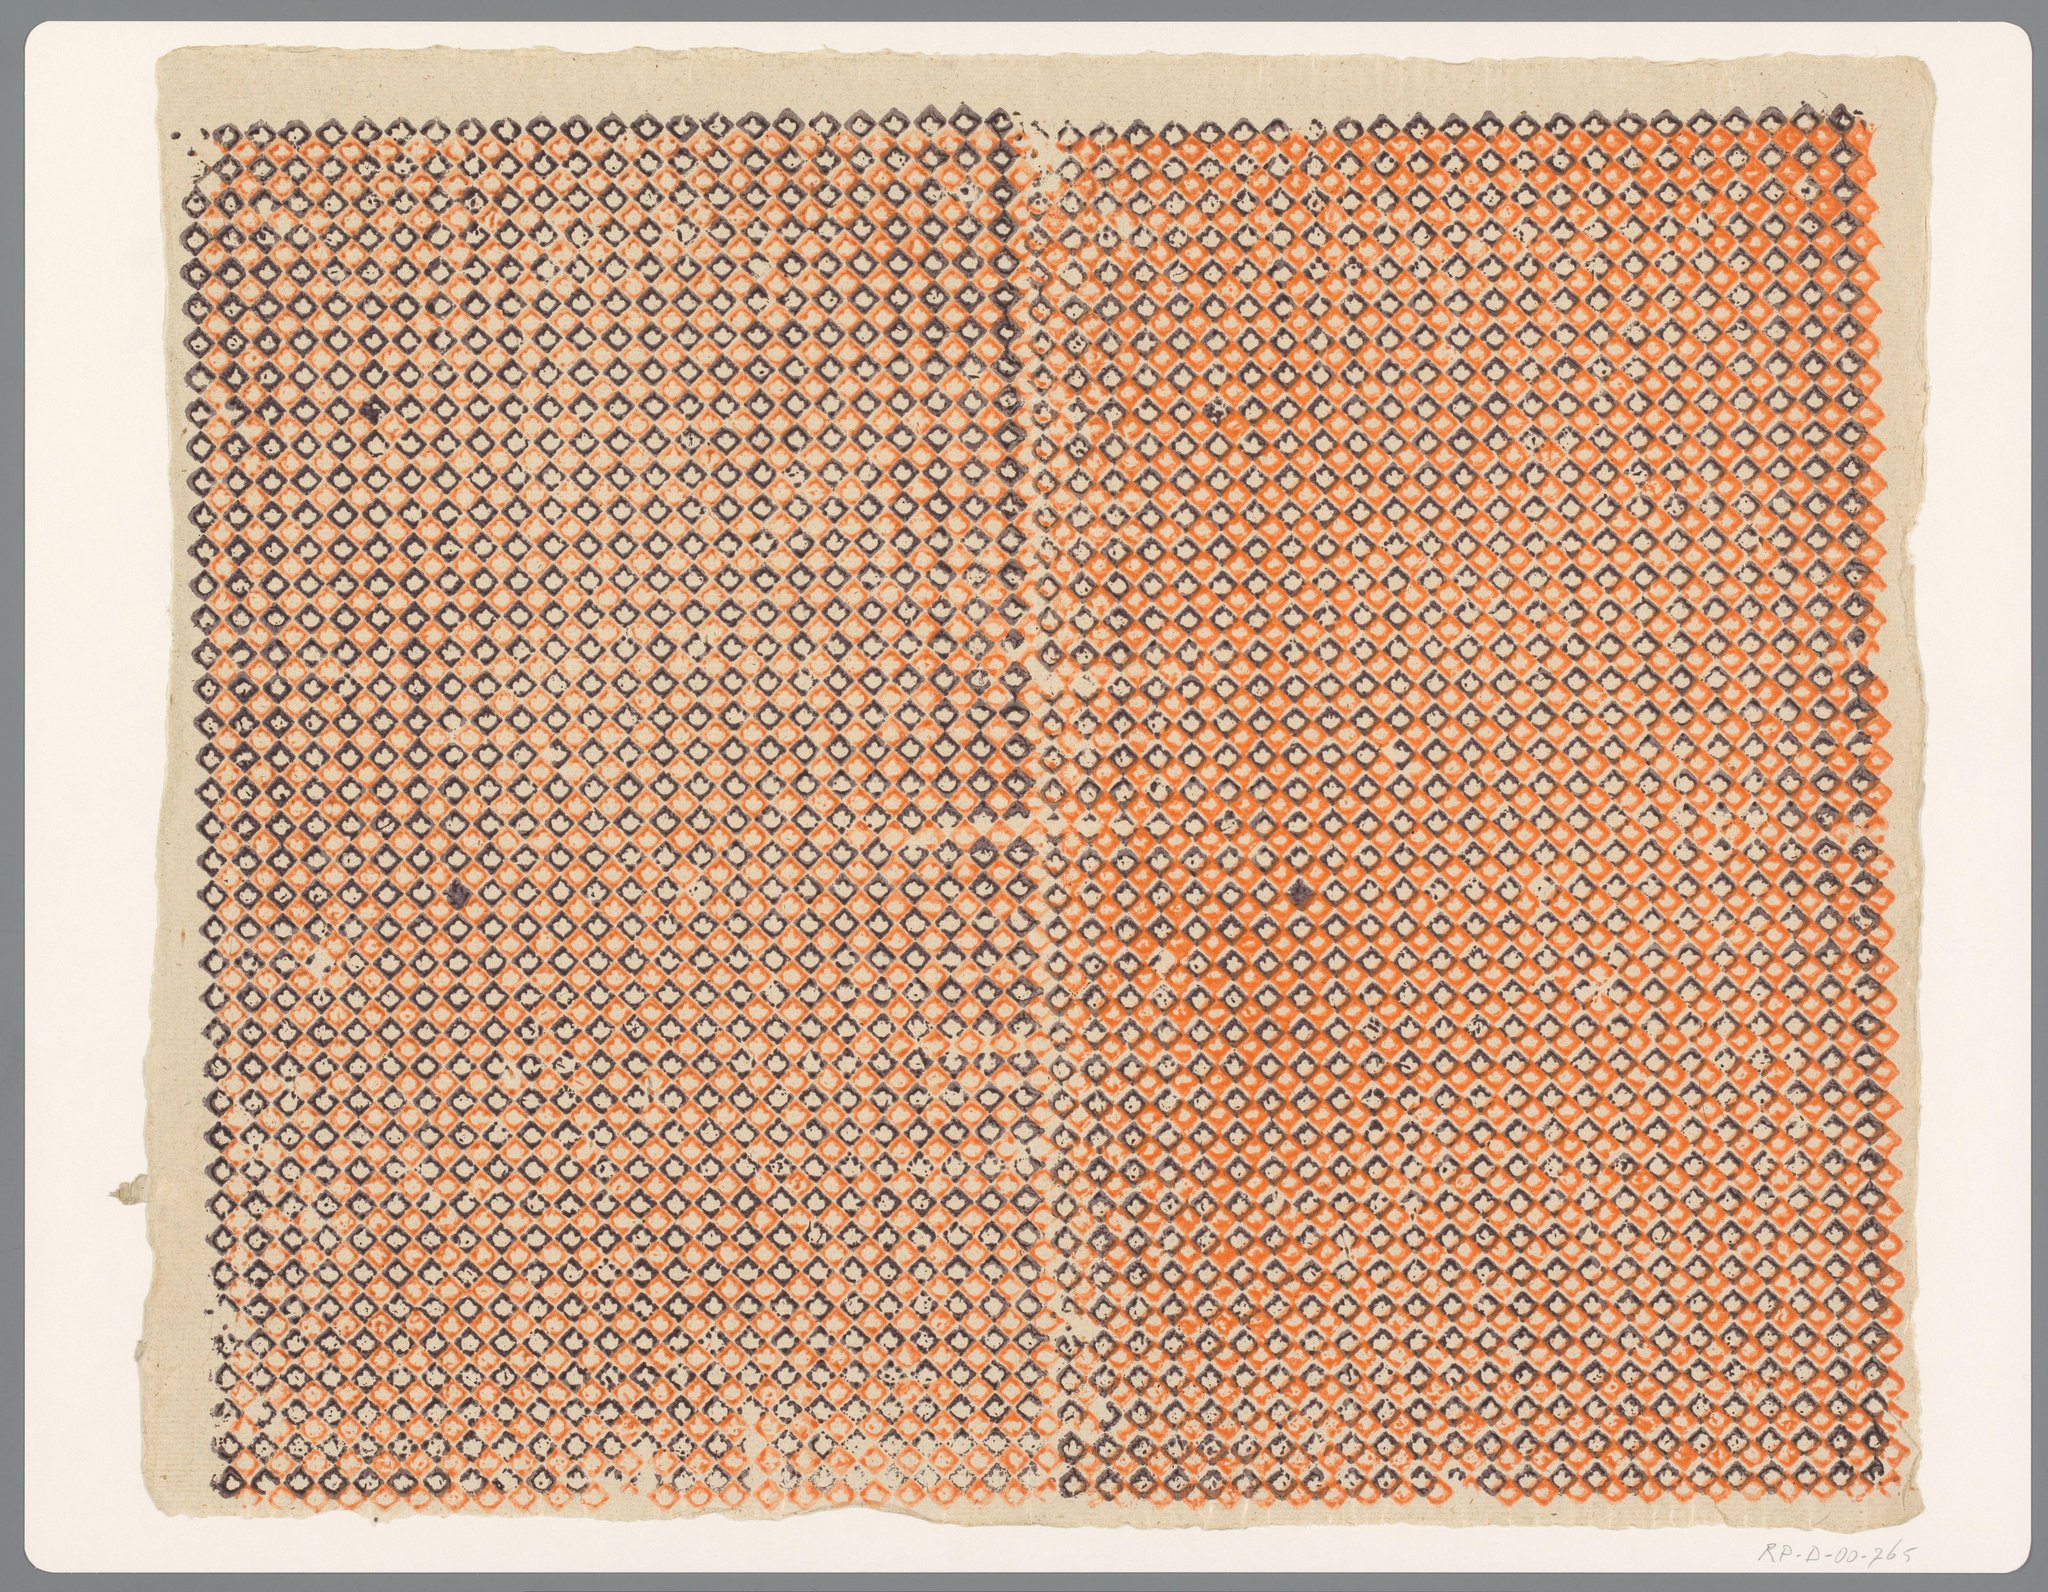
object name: printed paper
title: Blad met strooipatroon van blokjes met uitgespaard bladmotief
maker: Anonymous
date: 1750-1950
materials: lacquer, paper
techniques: printing block, lacquer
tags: ornament ~ geometric motifs, ornament derived from plant forms